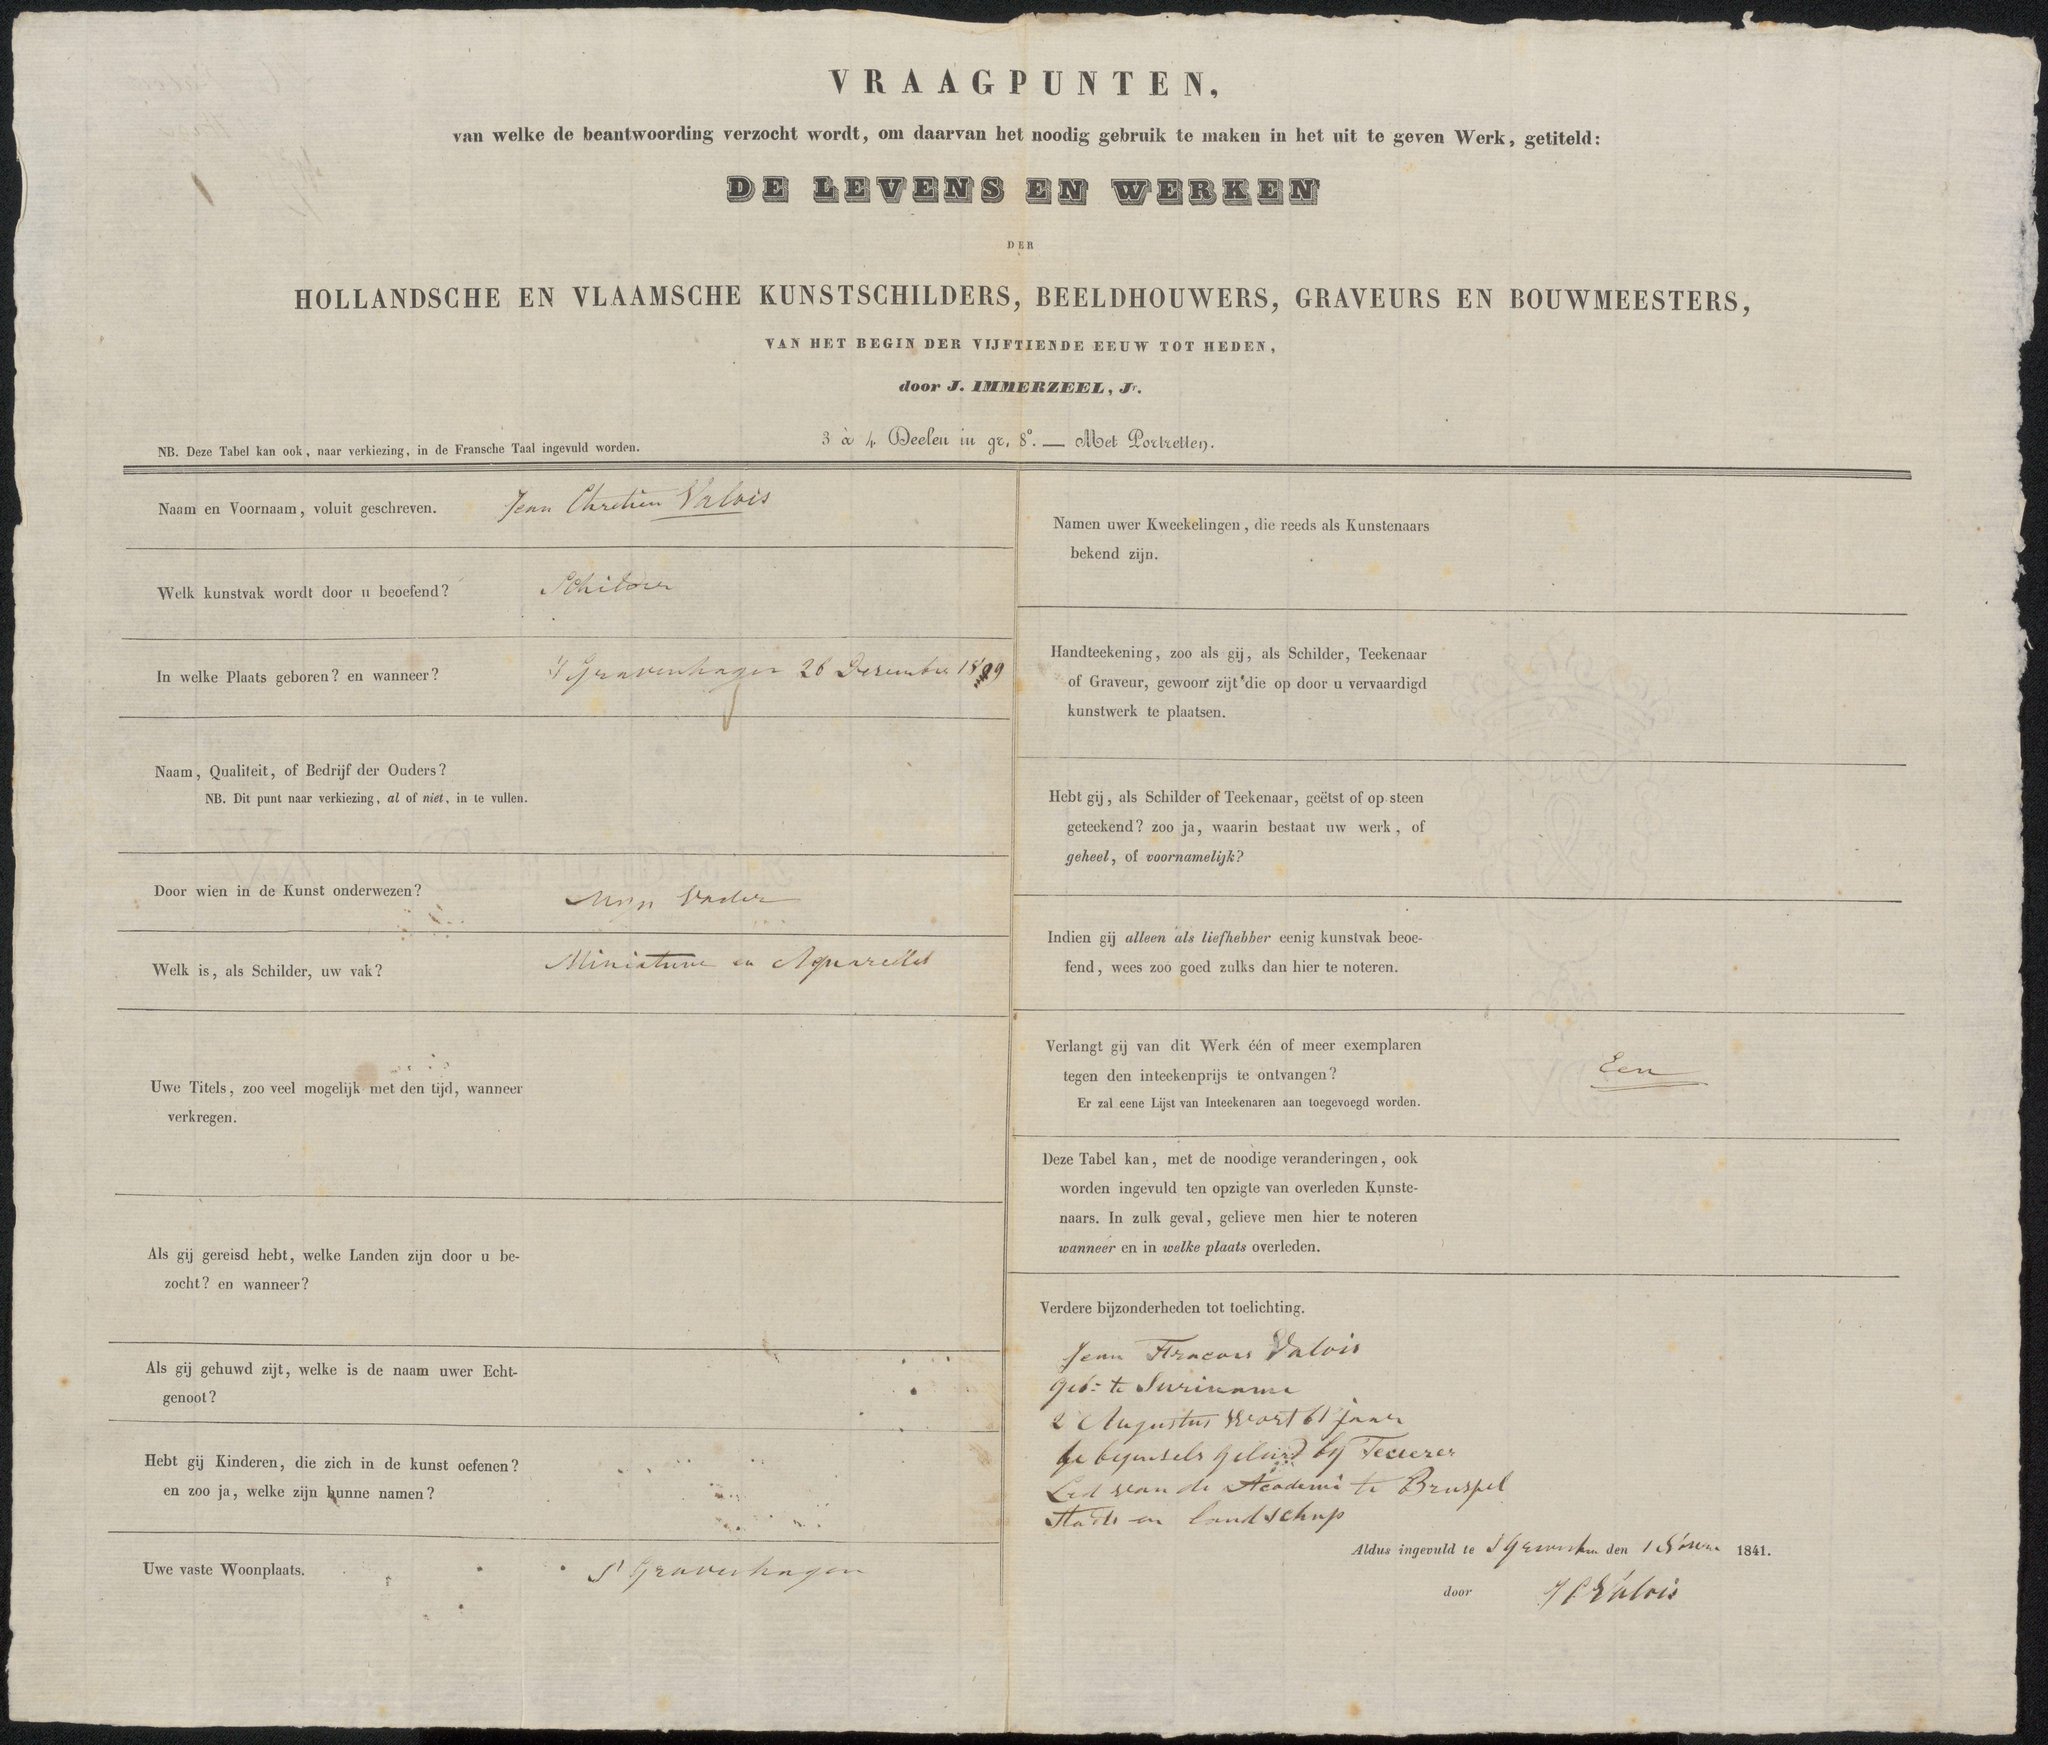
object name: manuscript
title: Enquêteformulier ingevuld door Jean Chrétien Valois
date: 1841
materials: ink, paper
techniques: pen, printing, writing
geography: the hague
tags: the hague, painter, draughtsman, jean chrétien valois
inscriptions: watermark, inscription: ‘Vraagpunten,/ van welke de beantwoording verzocht wordt, om daarvan het noodig gebruik te maken in het uit te geven Werk, getiteld: De levens en werken/ der Hollandsche en Vlaamsche kunstschilders, beeldhouwers,/ graveurs en bouwmeesters, van het begin der vijftiende eeuw tot heden/ door J. Immerzeel, Jr.’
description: Opgenomen in: Immerzeel, J. Jr., De levens en werken der Hollandsche en Vlaamsche kunstschilders, beeldhouwers, graveurs en bouwmeesters, van het begin der vijftiende eeuw tot heden, Amsterdam: J.C. van Kesteren, 1842-1843.